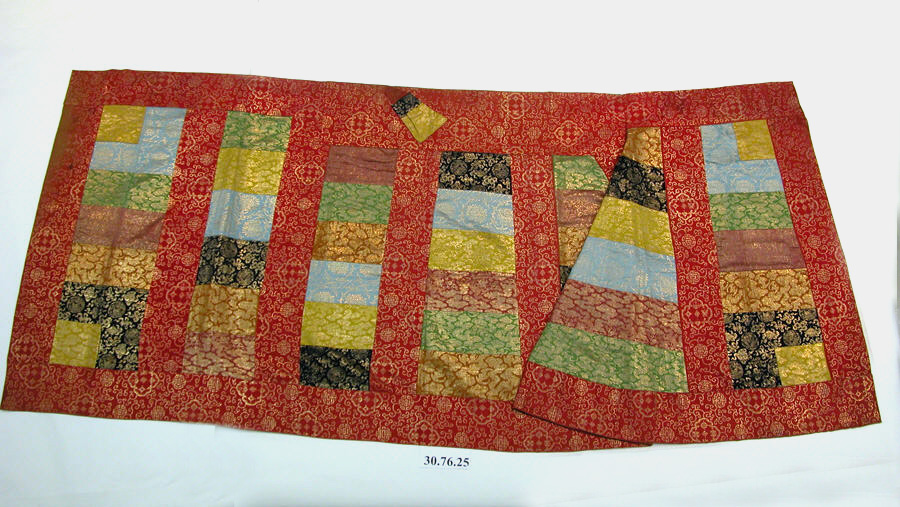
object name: robe, theatrical, for buddhist priest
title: Theatrical robe for a Buddhist priest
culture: chinese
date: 1701-1800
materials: silk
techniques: brocade